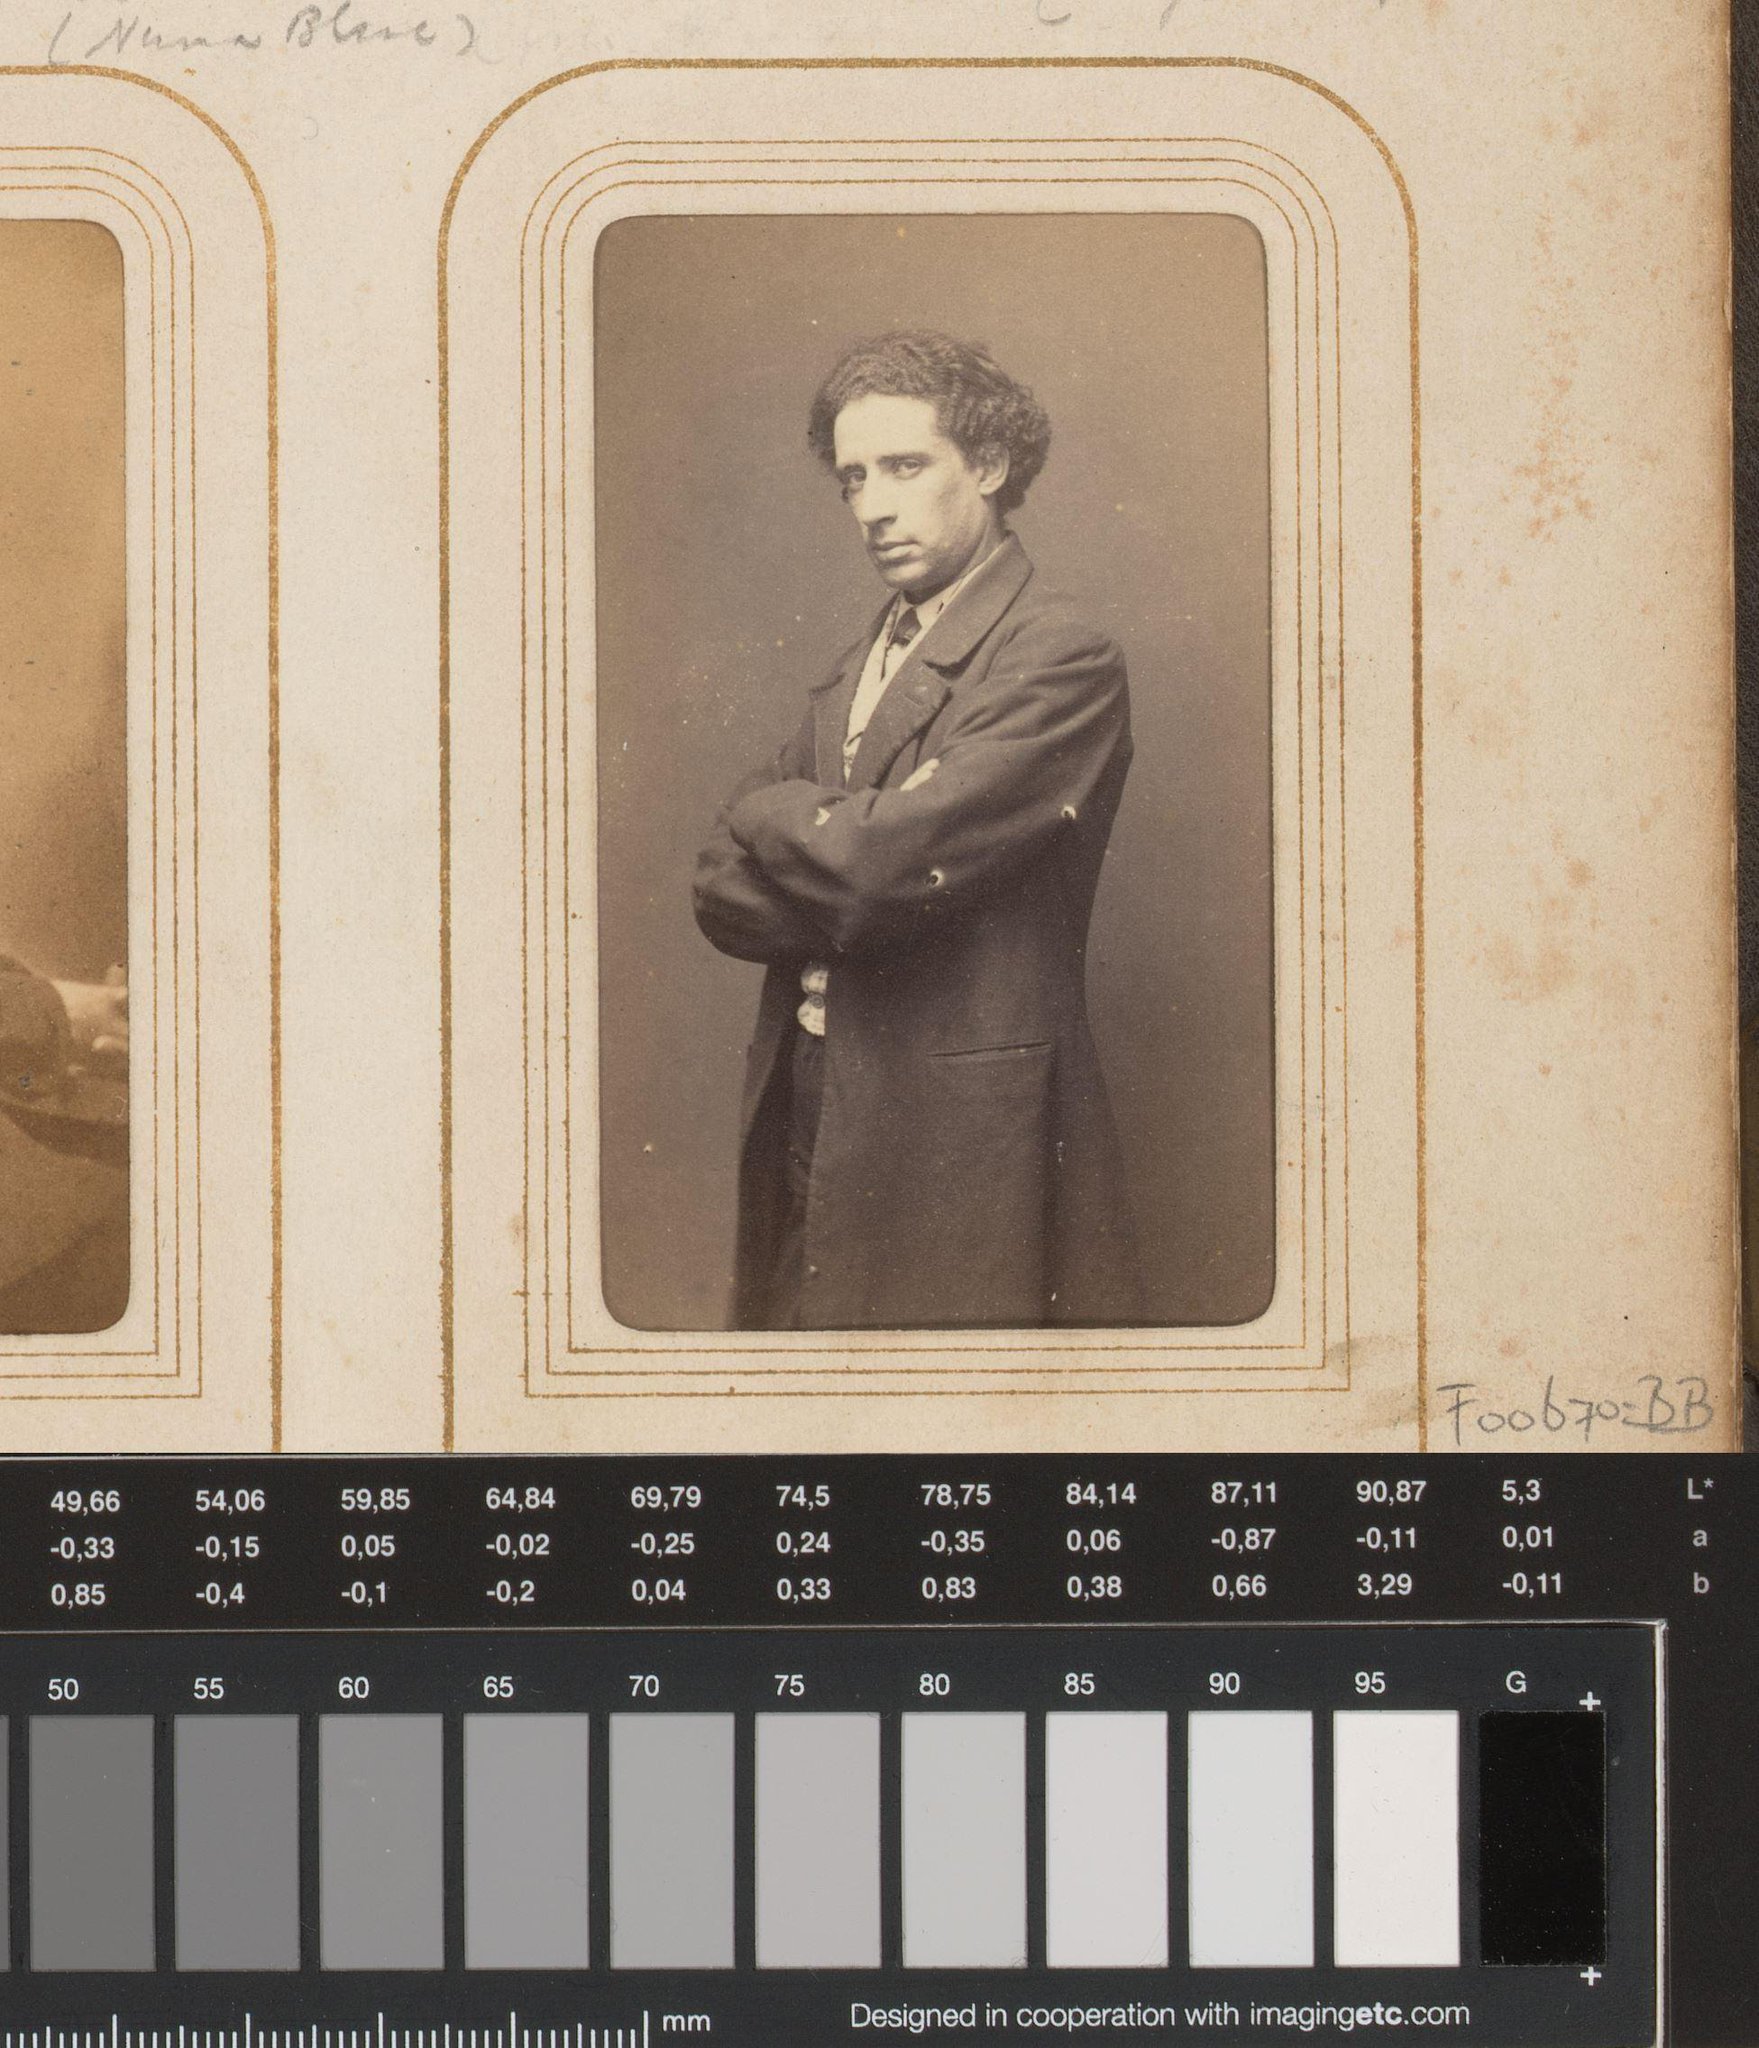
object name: photograph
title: Portret van Olivier Metra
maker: georges mathurin legé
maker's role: fotograaf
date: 1867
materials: cardboard, photographic support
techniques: albumen print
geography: paris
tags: historical persons, portrait of composer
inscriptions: inscription: ‘G.M. Legé/ Photographe/ ancien associé, succr/ De Carjat & Cie/ 56, Rue Laffitte/ Paris’, name: ‘Metra’, annotation: ‘Olivier Metra fr. componist en dirigent/ (Legé - Carjat)’